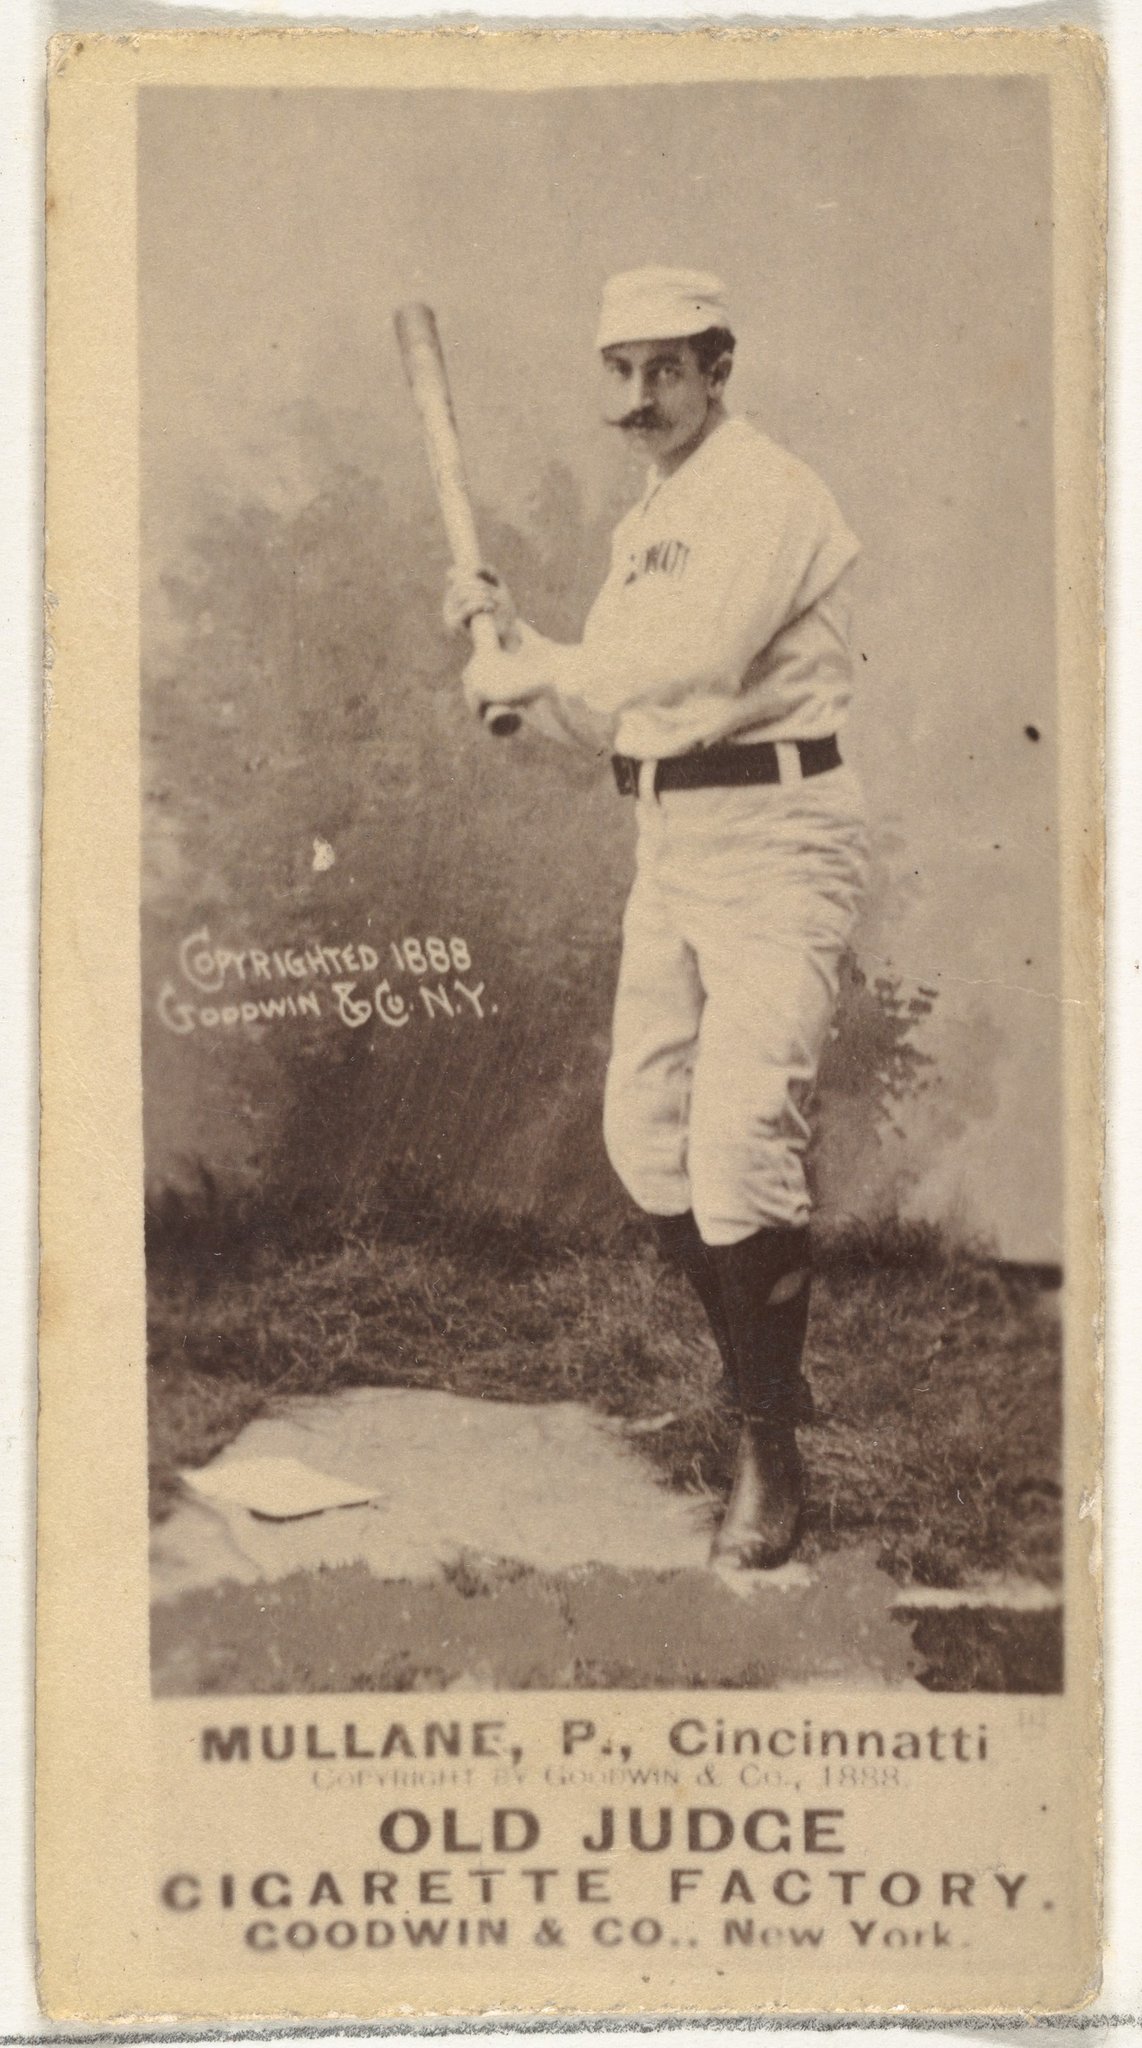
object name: baseball card, photograph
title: Anthony John "Tony" Mullane, Pitcher, Cincinnati, from the Old Judge series (N172) for Old Judge Cigarettes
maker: goodwin & company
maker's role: publisher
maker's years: 1850-1950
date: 1888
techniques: albumen silver print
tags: men,portraits,baseball,athletes